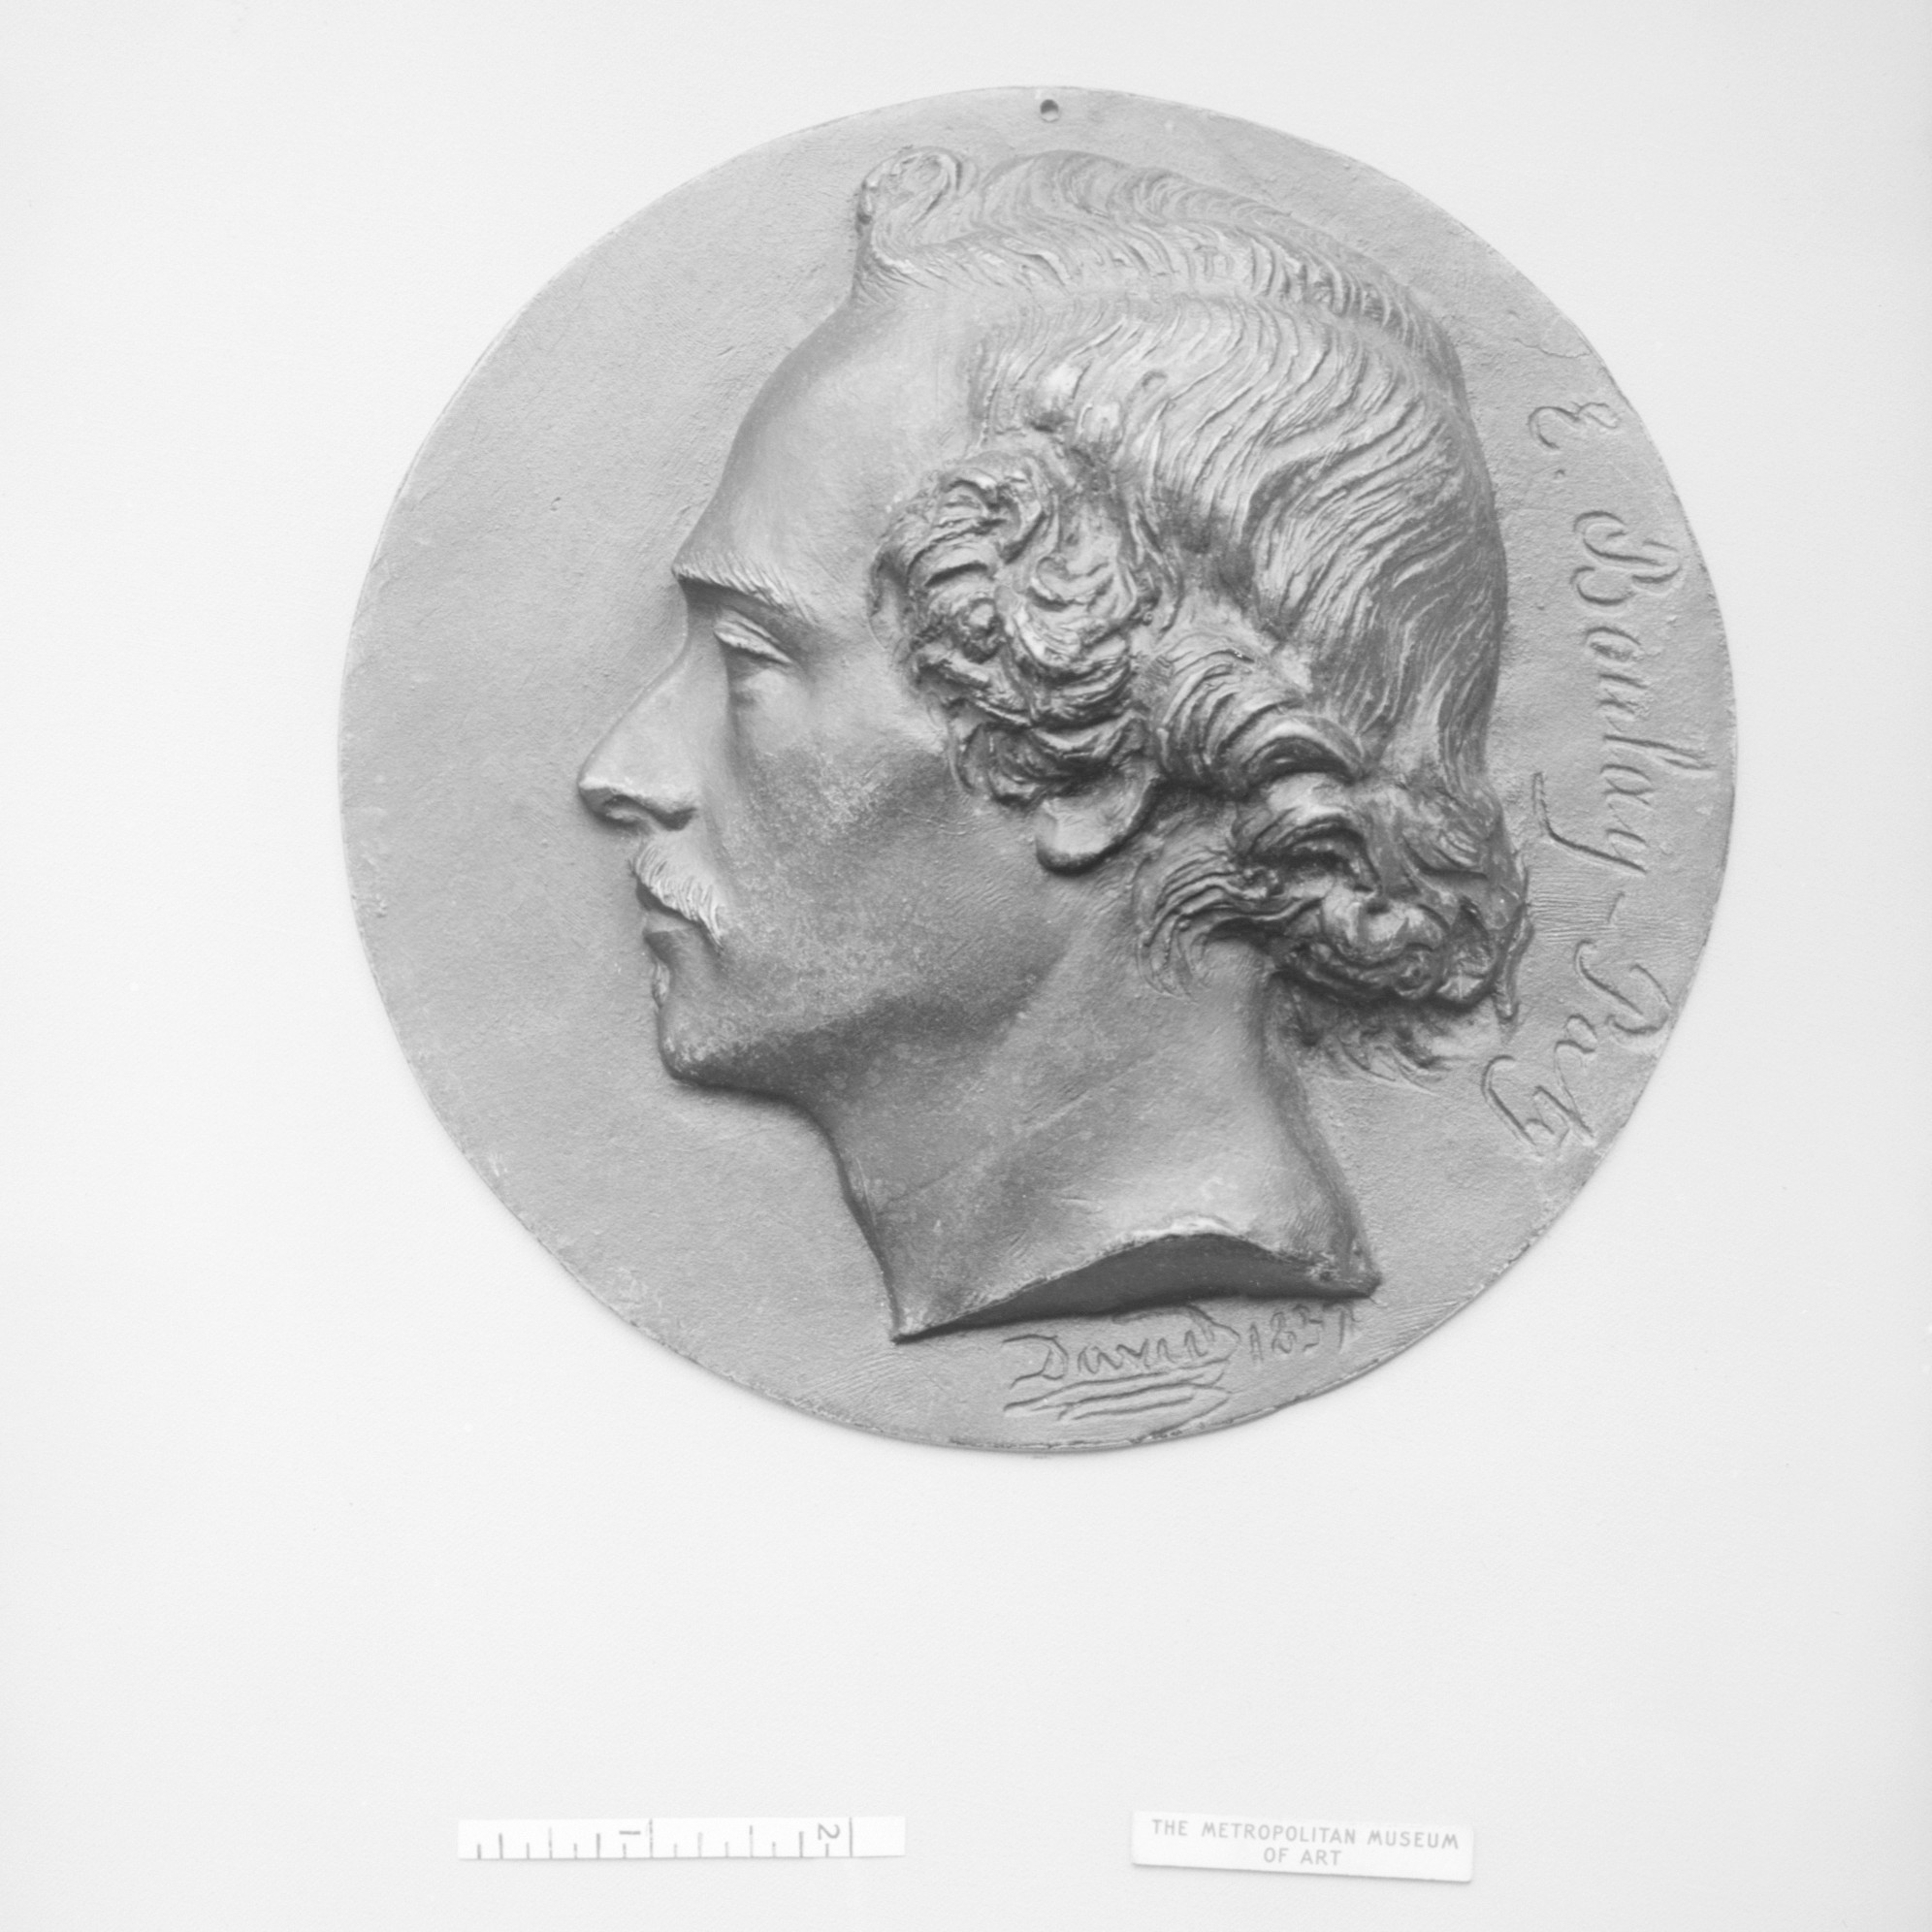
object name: medallion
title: Evariste Boulay-Paty (1804–1864), French poet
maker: pierre jean david d'angers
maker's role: artist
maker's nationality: french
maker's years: 1788-1856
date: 1847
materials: bronze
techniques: casting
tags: men,profiles